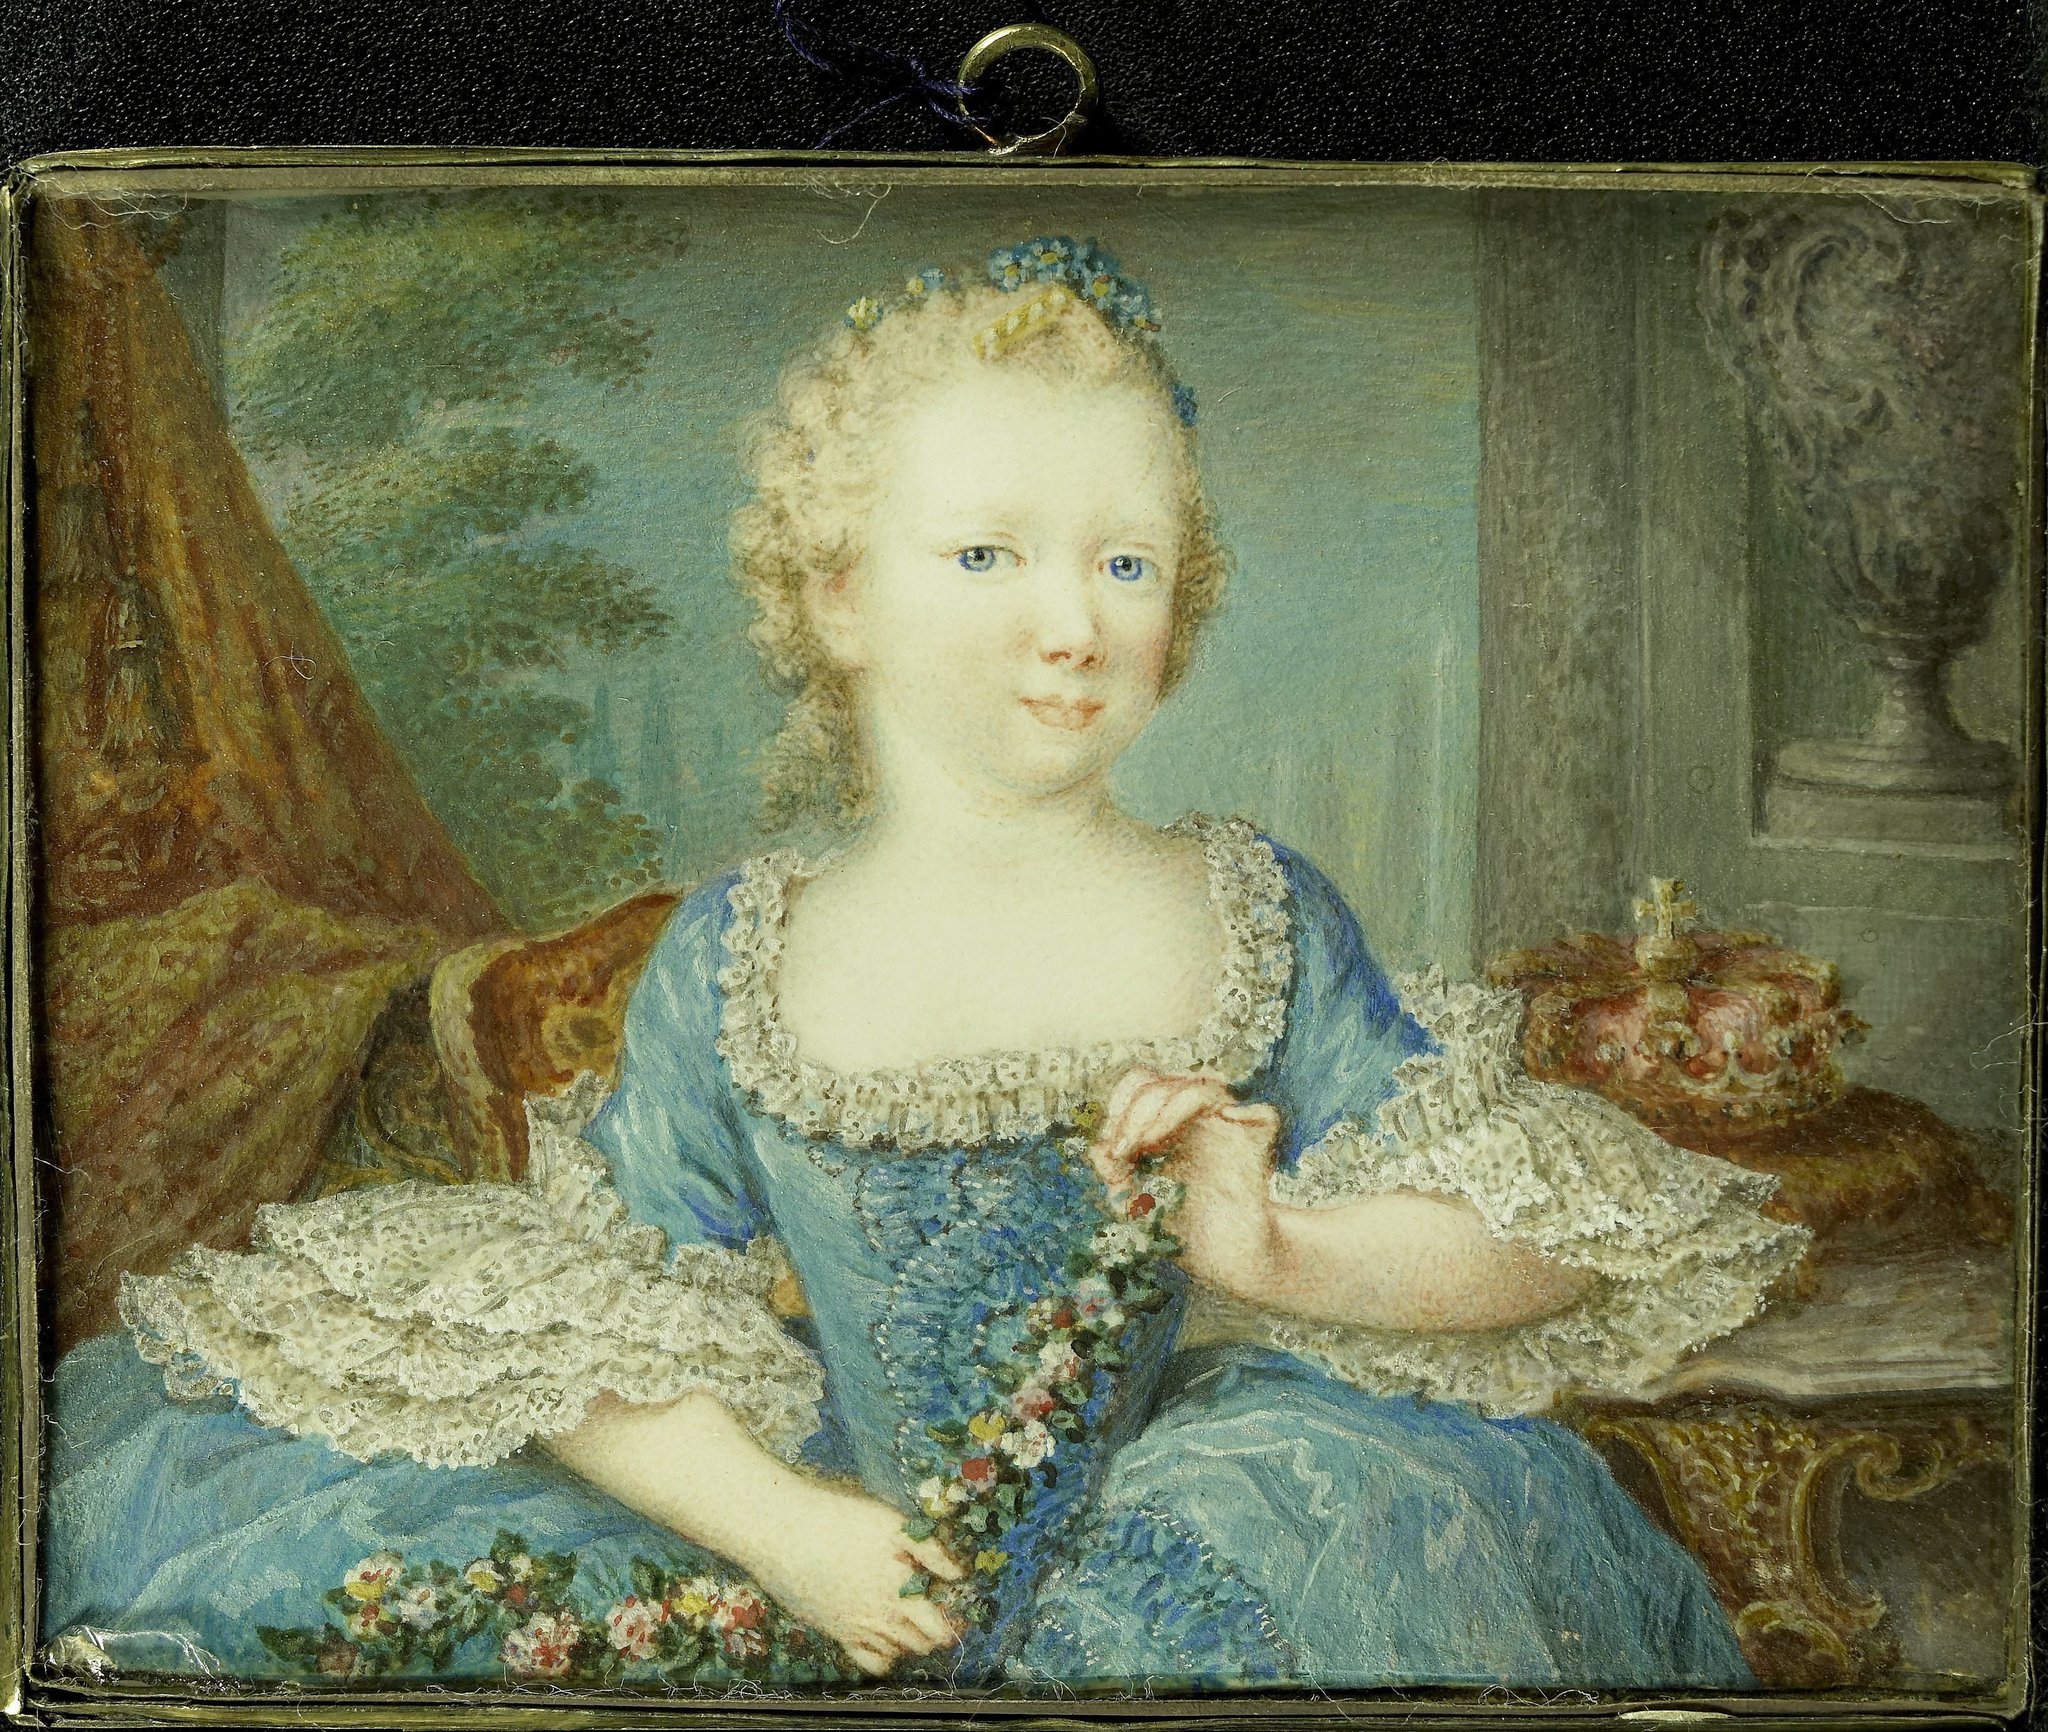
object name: painting, miniature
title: Wilhelmina Carolina (Carolina; 1743-87), prinses van Oranje-Nassau, dochter van Willem IV en zuster van Willem V, als kind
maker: robert mussard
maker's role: miniatuurschilder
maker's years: 1713-1777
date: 1743-1755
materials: cardboard, glass, metal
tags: carolina (prinses van oranje-nassau)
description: Portret van Wilhelmina Carolina (1743-87), prinses van Oranje-Nassau, dochter van Willem IV en zuster van Willem V, als kind. Ten halven lijve, zittend, een bloemenkrans in de handen. Rechts een tafeltje en een tuinvaas, links een (geschilderd?) landschap. Onderdeel van de collectie portretminiaturen.